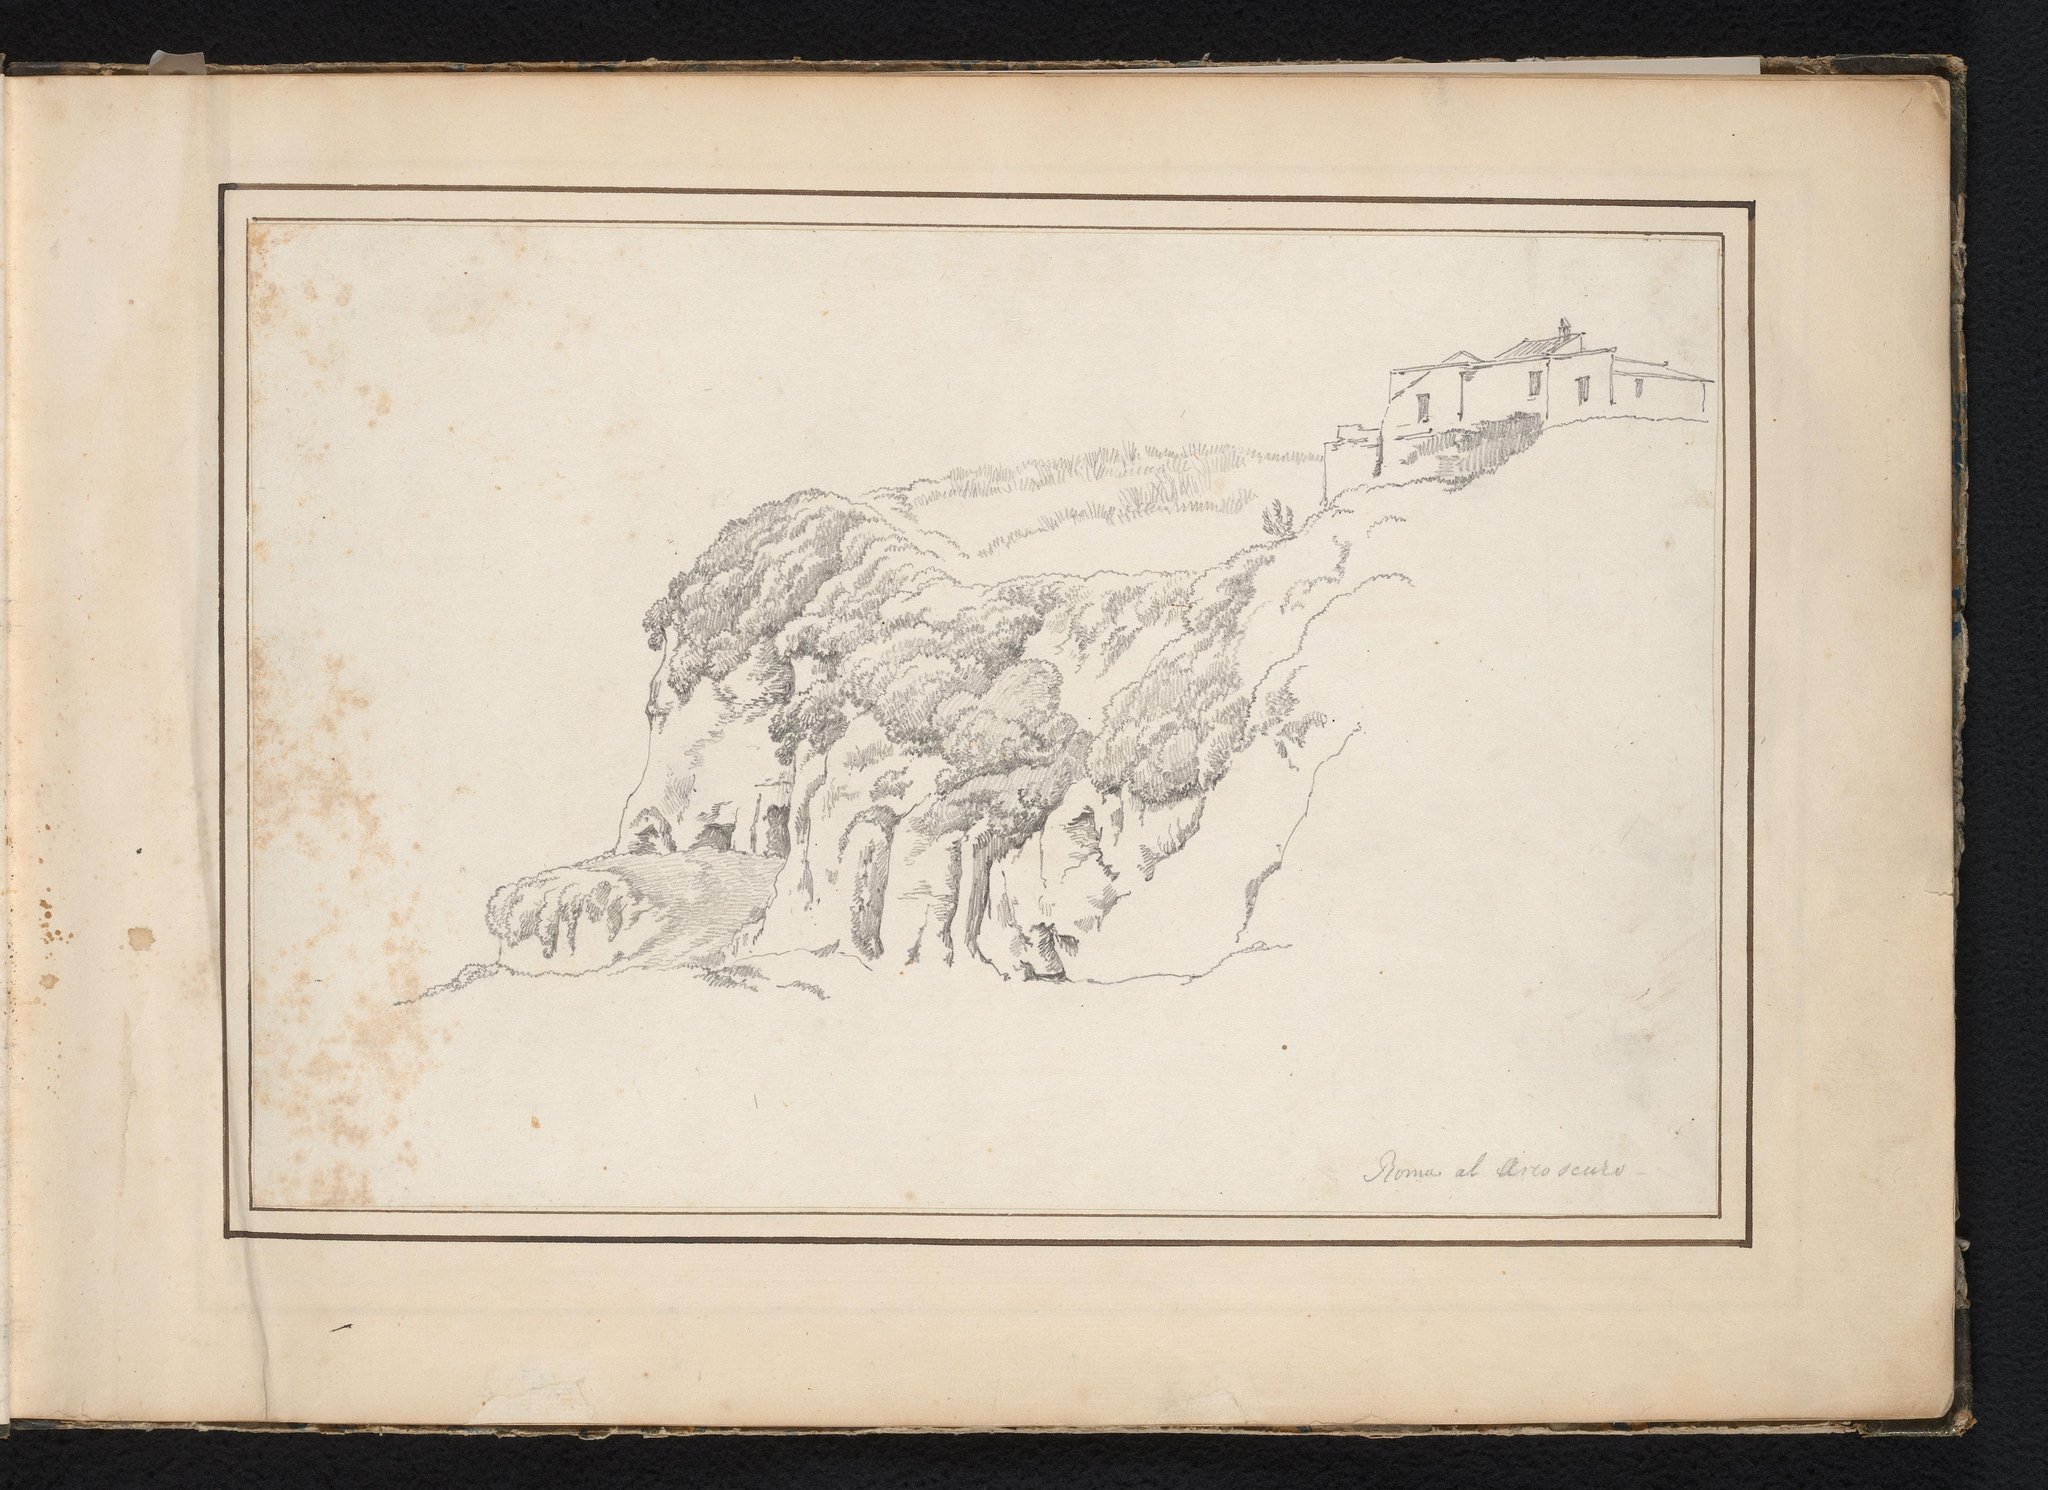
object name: album leaf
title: Rotsen met bovenop een gebouw te Rome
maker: hendrik voogd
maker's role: draughtsman, painter, print maker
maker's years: 1768-1839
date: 1788-1839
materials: paper, pencil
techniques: pasting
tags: city-view, and landscape with man-made constructions, low hill country, landscapes, rome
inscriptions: inscription: ‘Roma al Airo scuro’